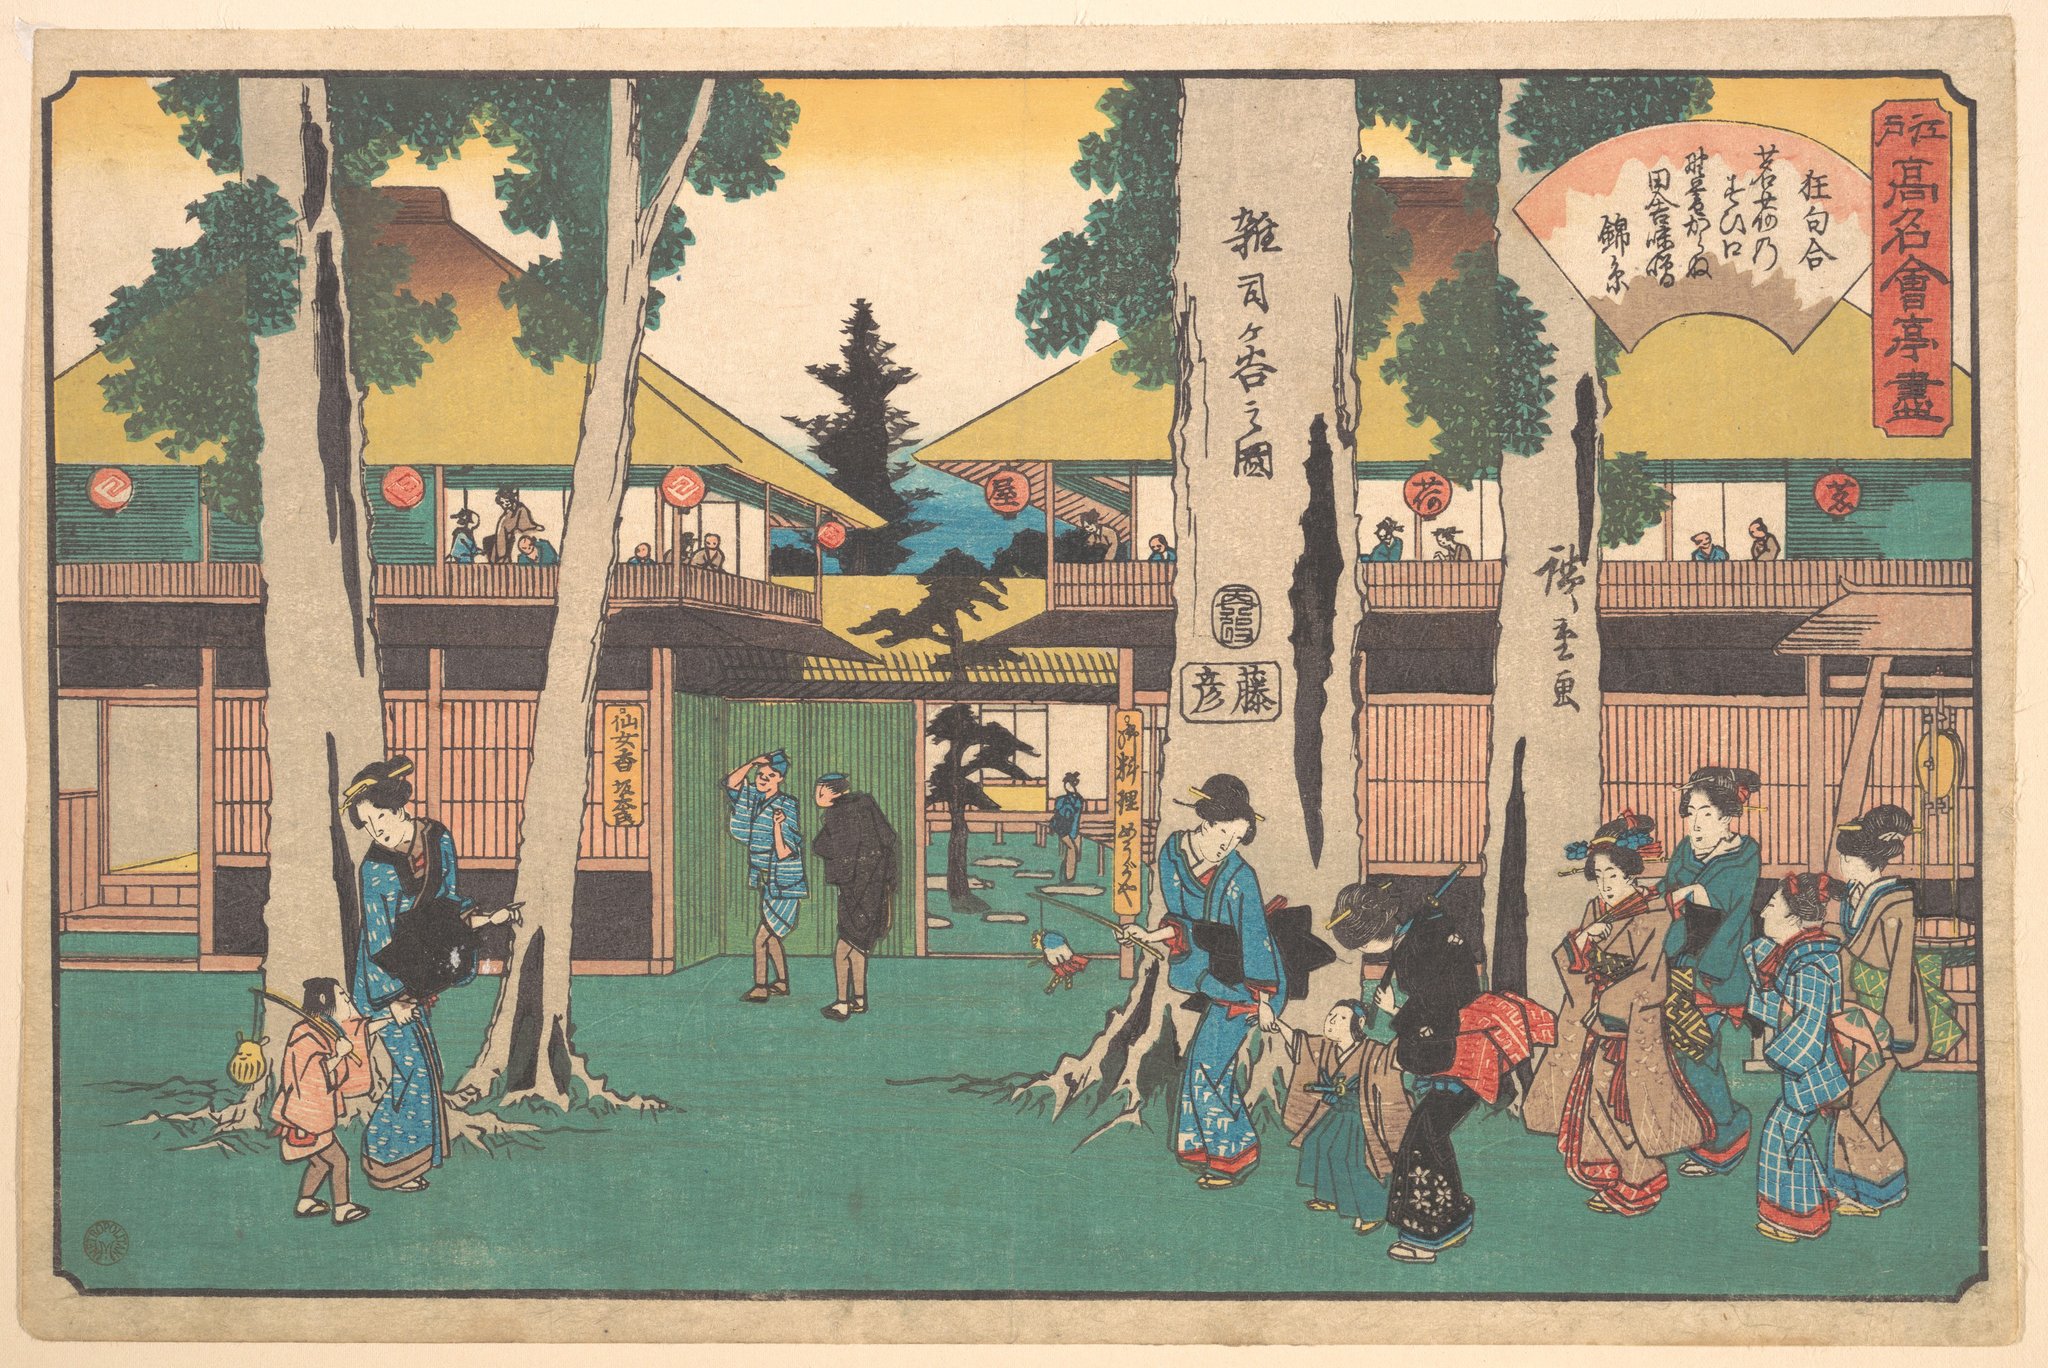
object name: print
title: Zoshigaya no Zu (Myoga-ya)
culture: japanese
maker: utagawa hiroshige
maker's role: artist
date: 1840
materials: ink, paper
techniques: woodblock print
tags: boys,men,women,trees